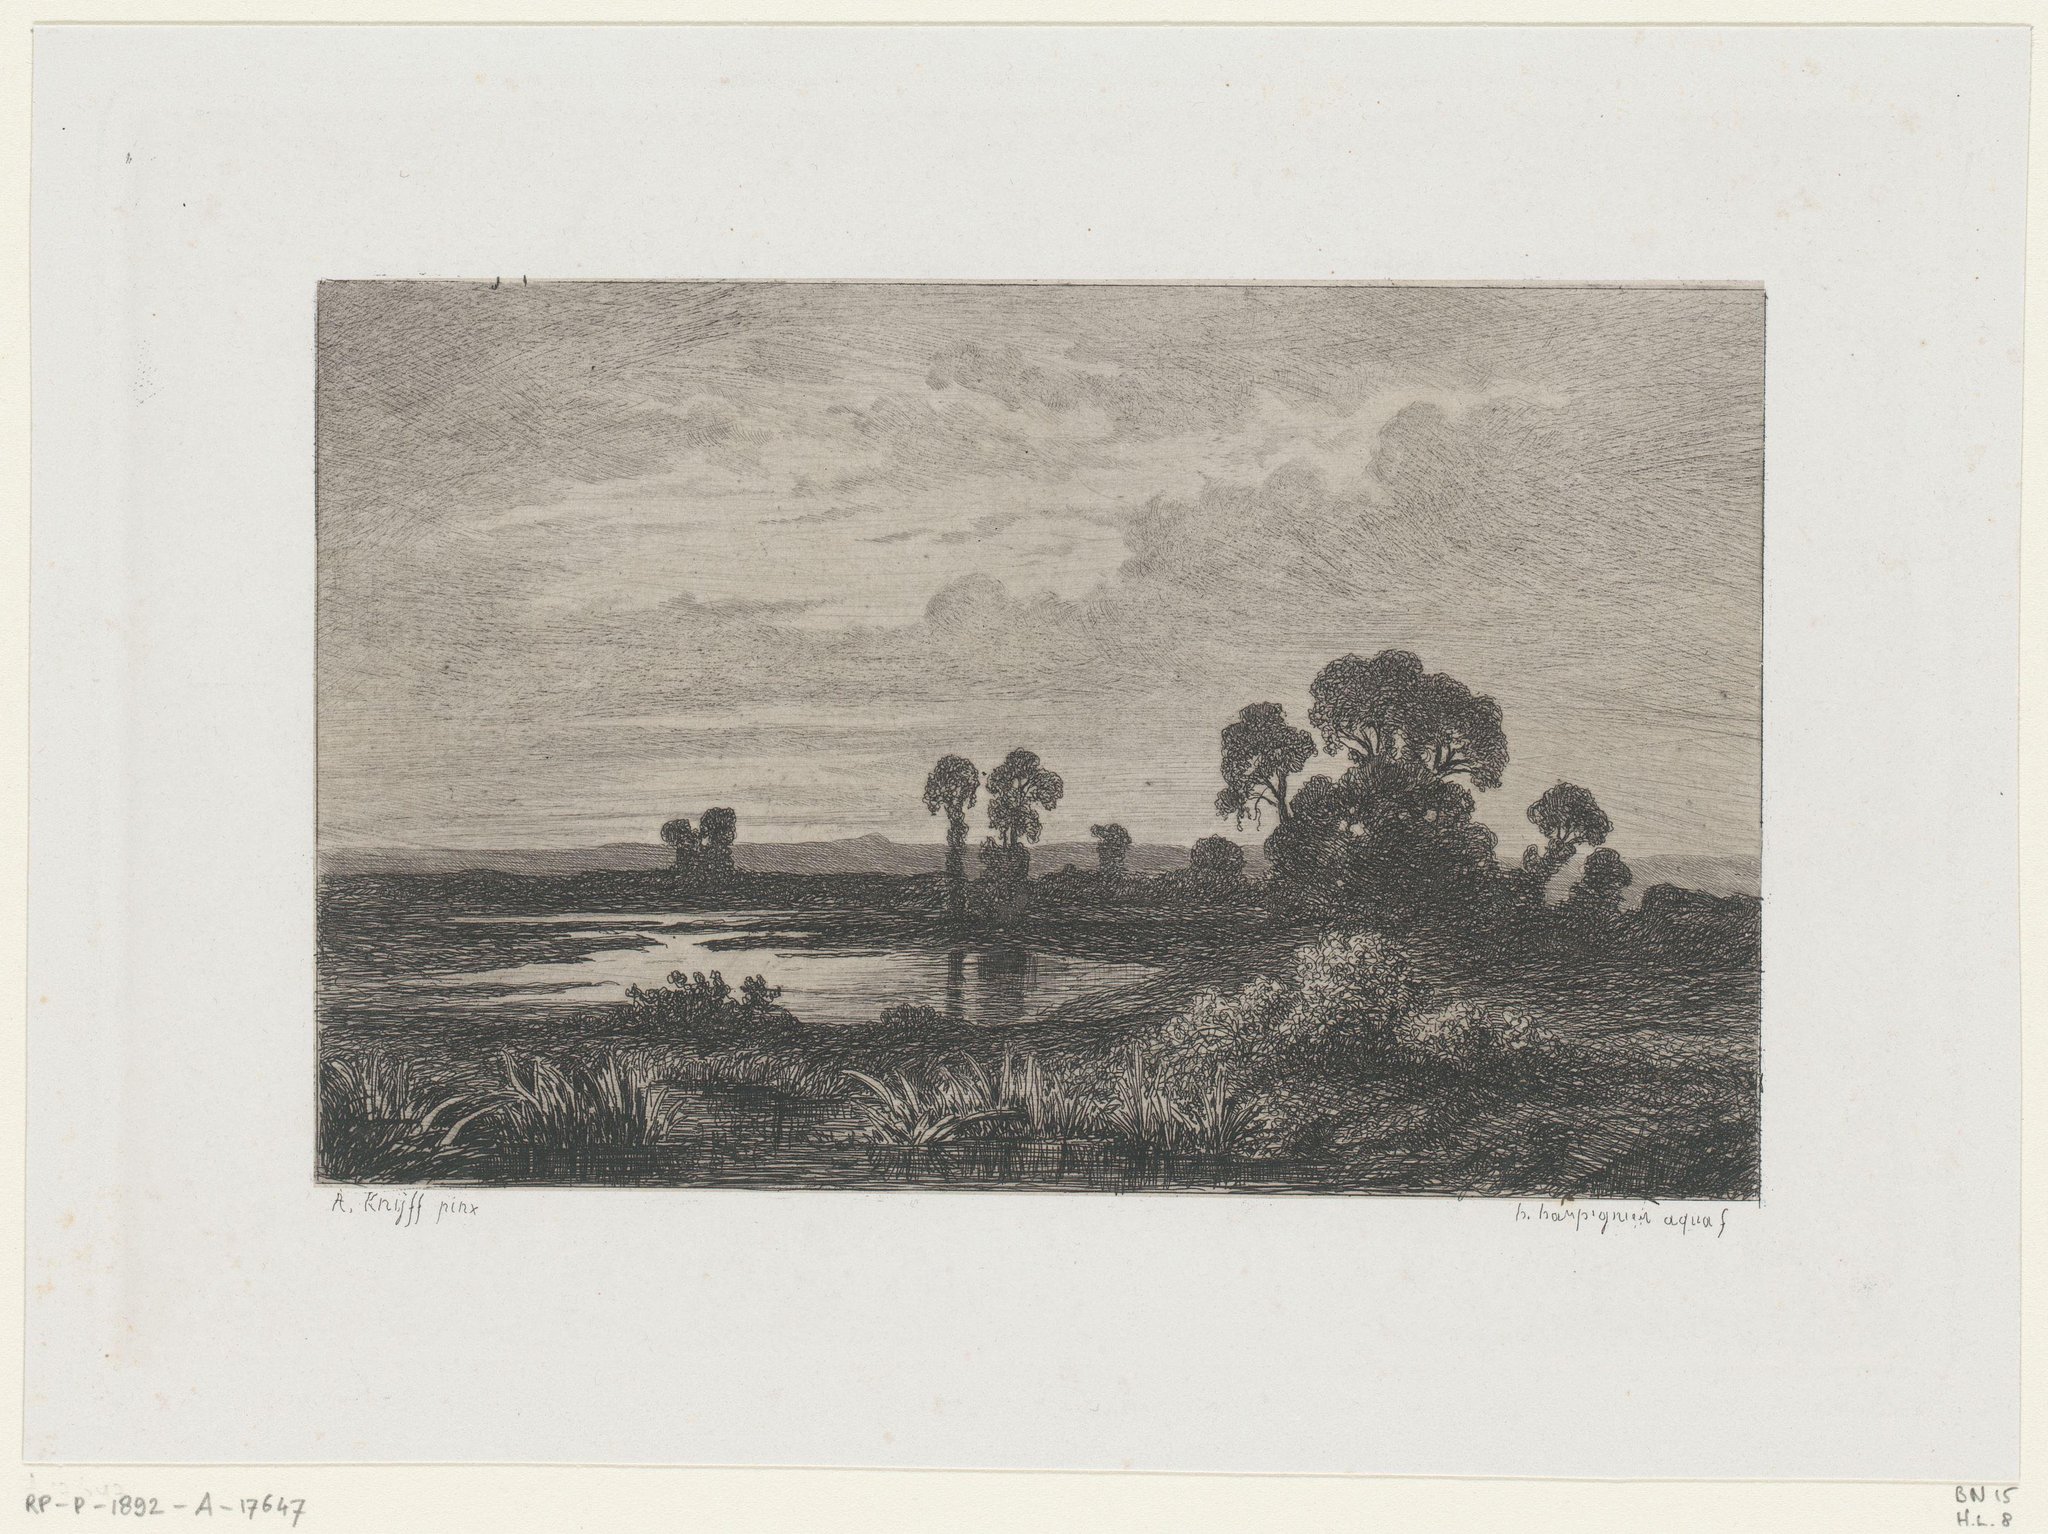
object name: print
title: Landschap met bomen bij een plas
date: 1850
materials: paper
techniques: etching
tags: landscapes, pond, pool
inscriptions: collector's mark: Lugt 2228